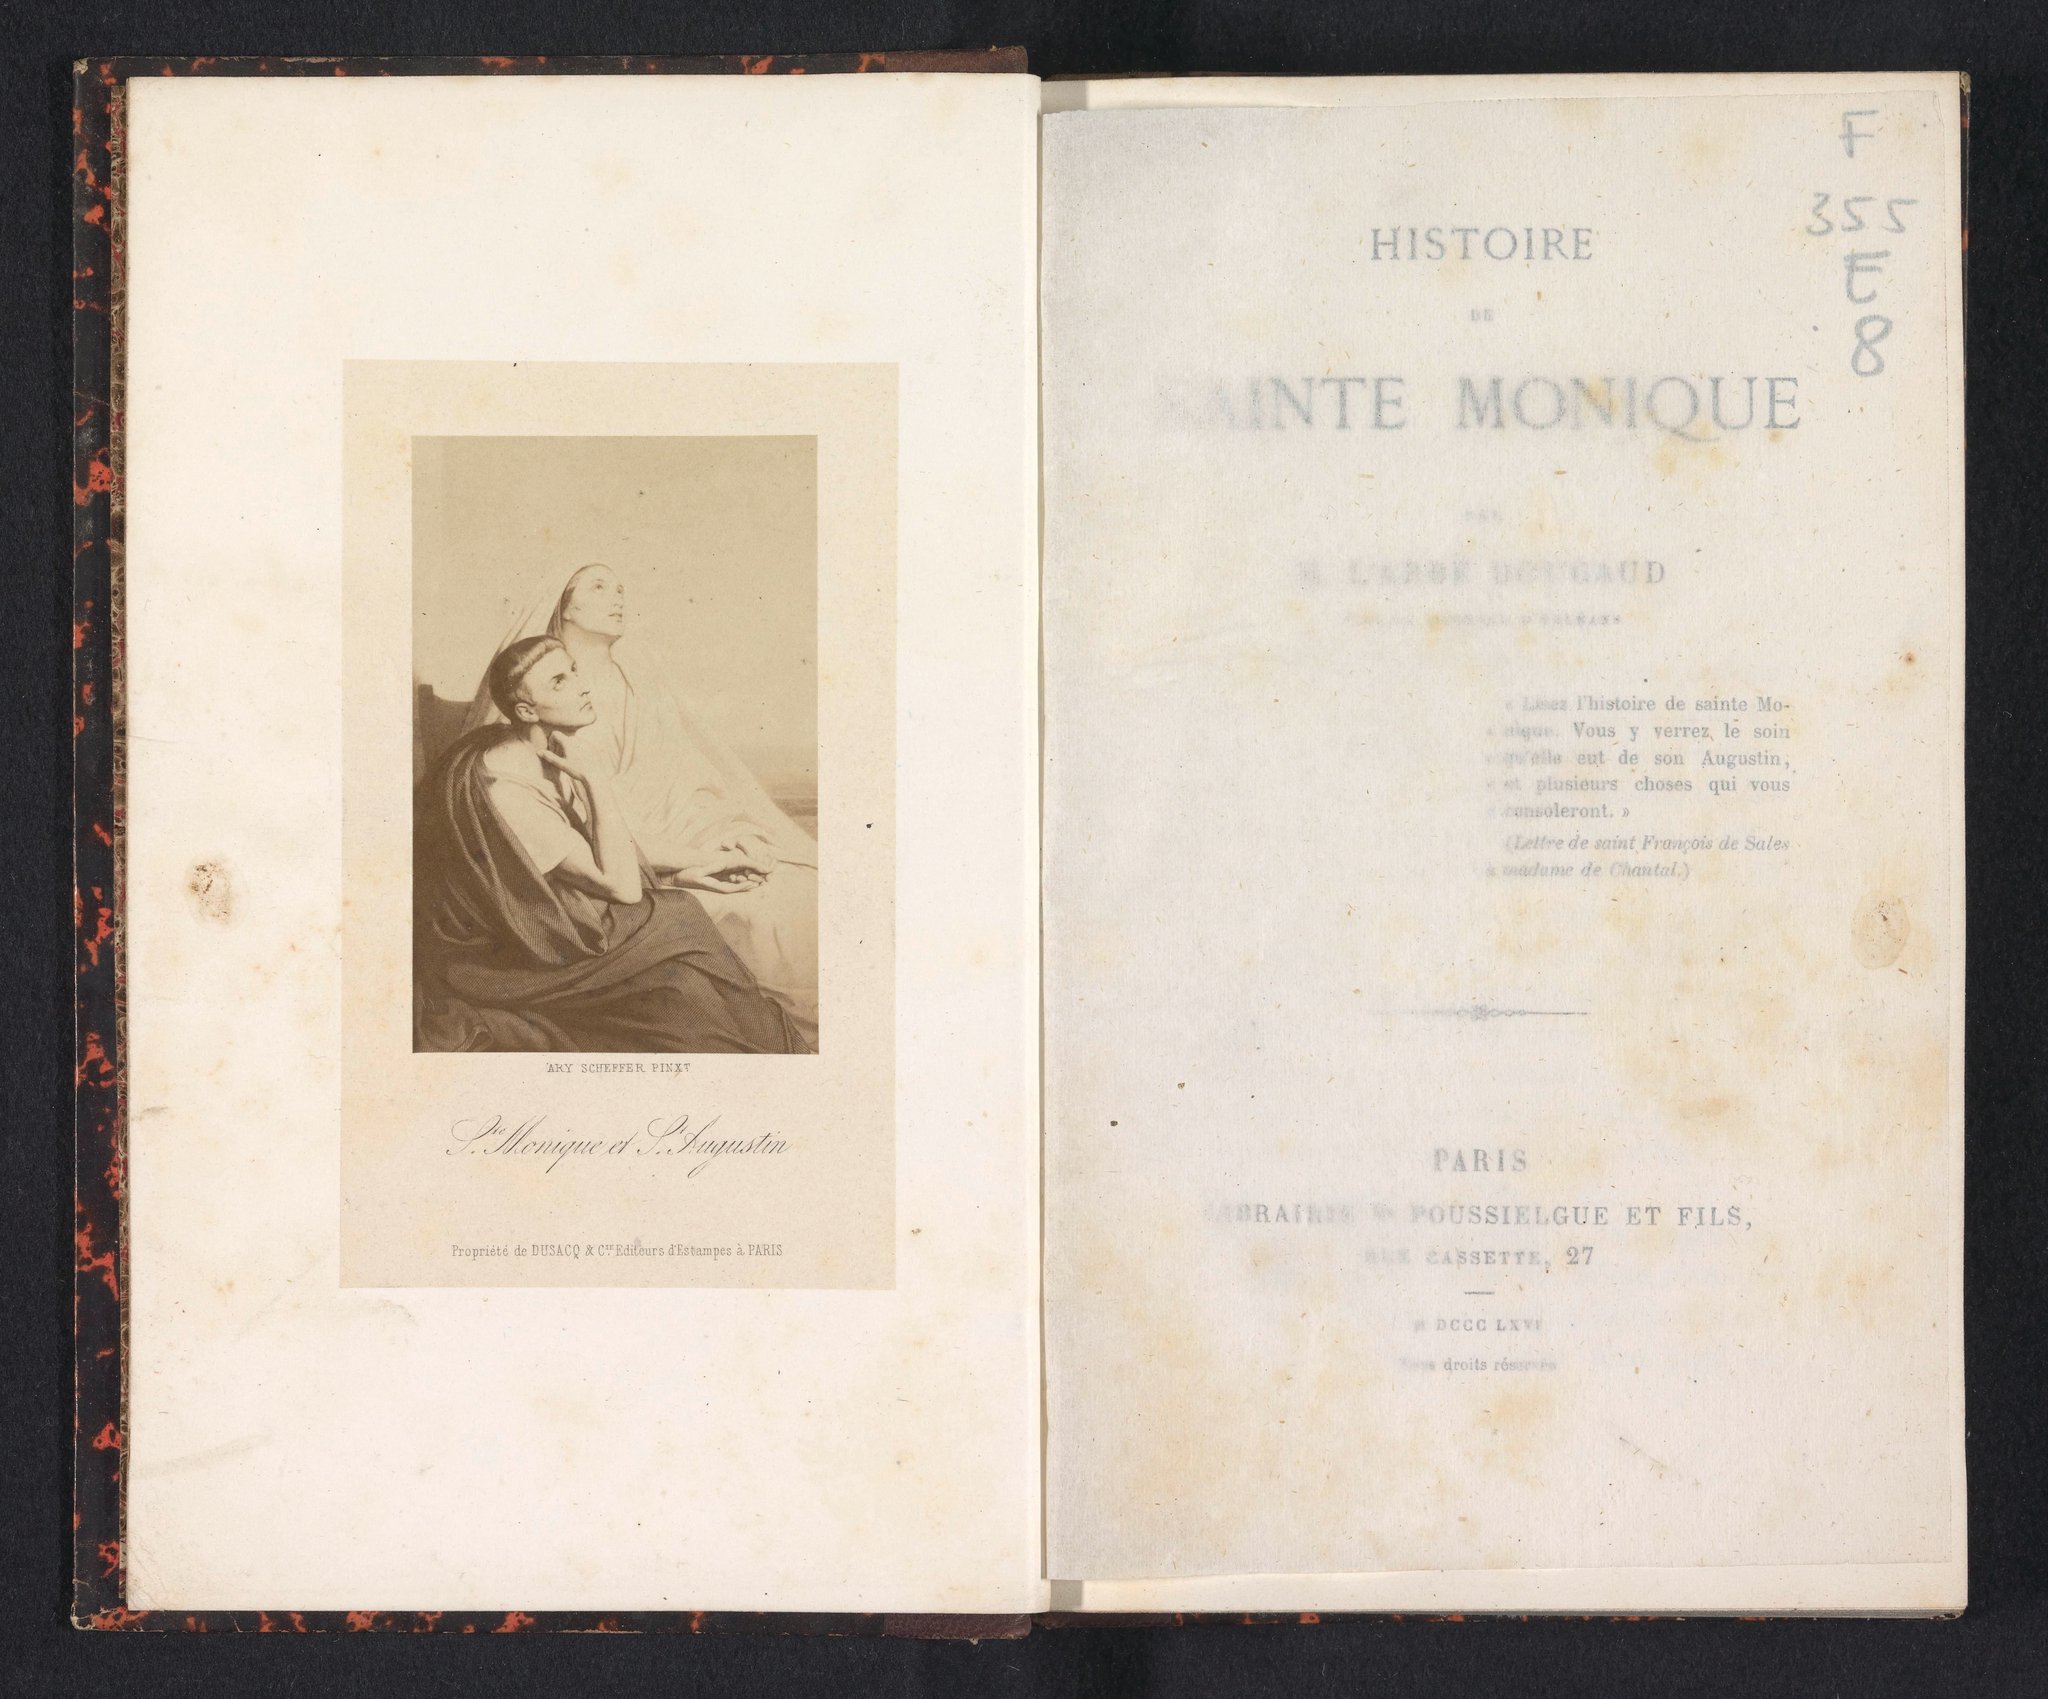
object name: reproduction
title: Ste Monique et St Augustin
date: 1856-1866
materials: photographic support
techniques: albumen print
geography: france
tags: st. monica and st. augustine in ostia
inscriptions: inscription: ‘Propriété de Dusacq & Cie Editeurs d'Estampes à Paris’